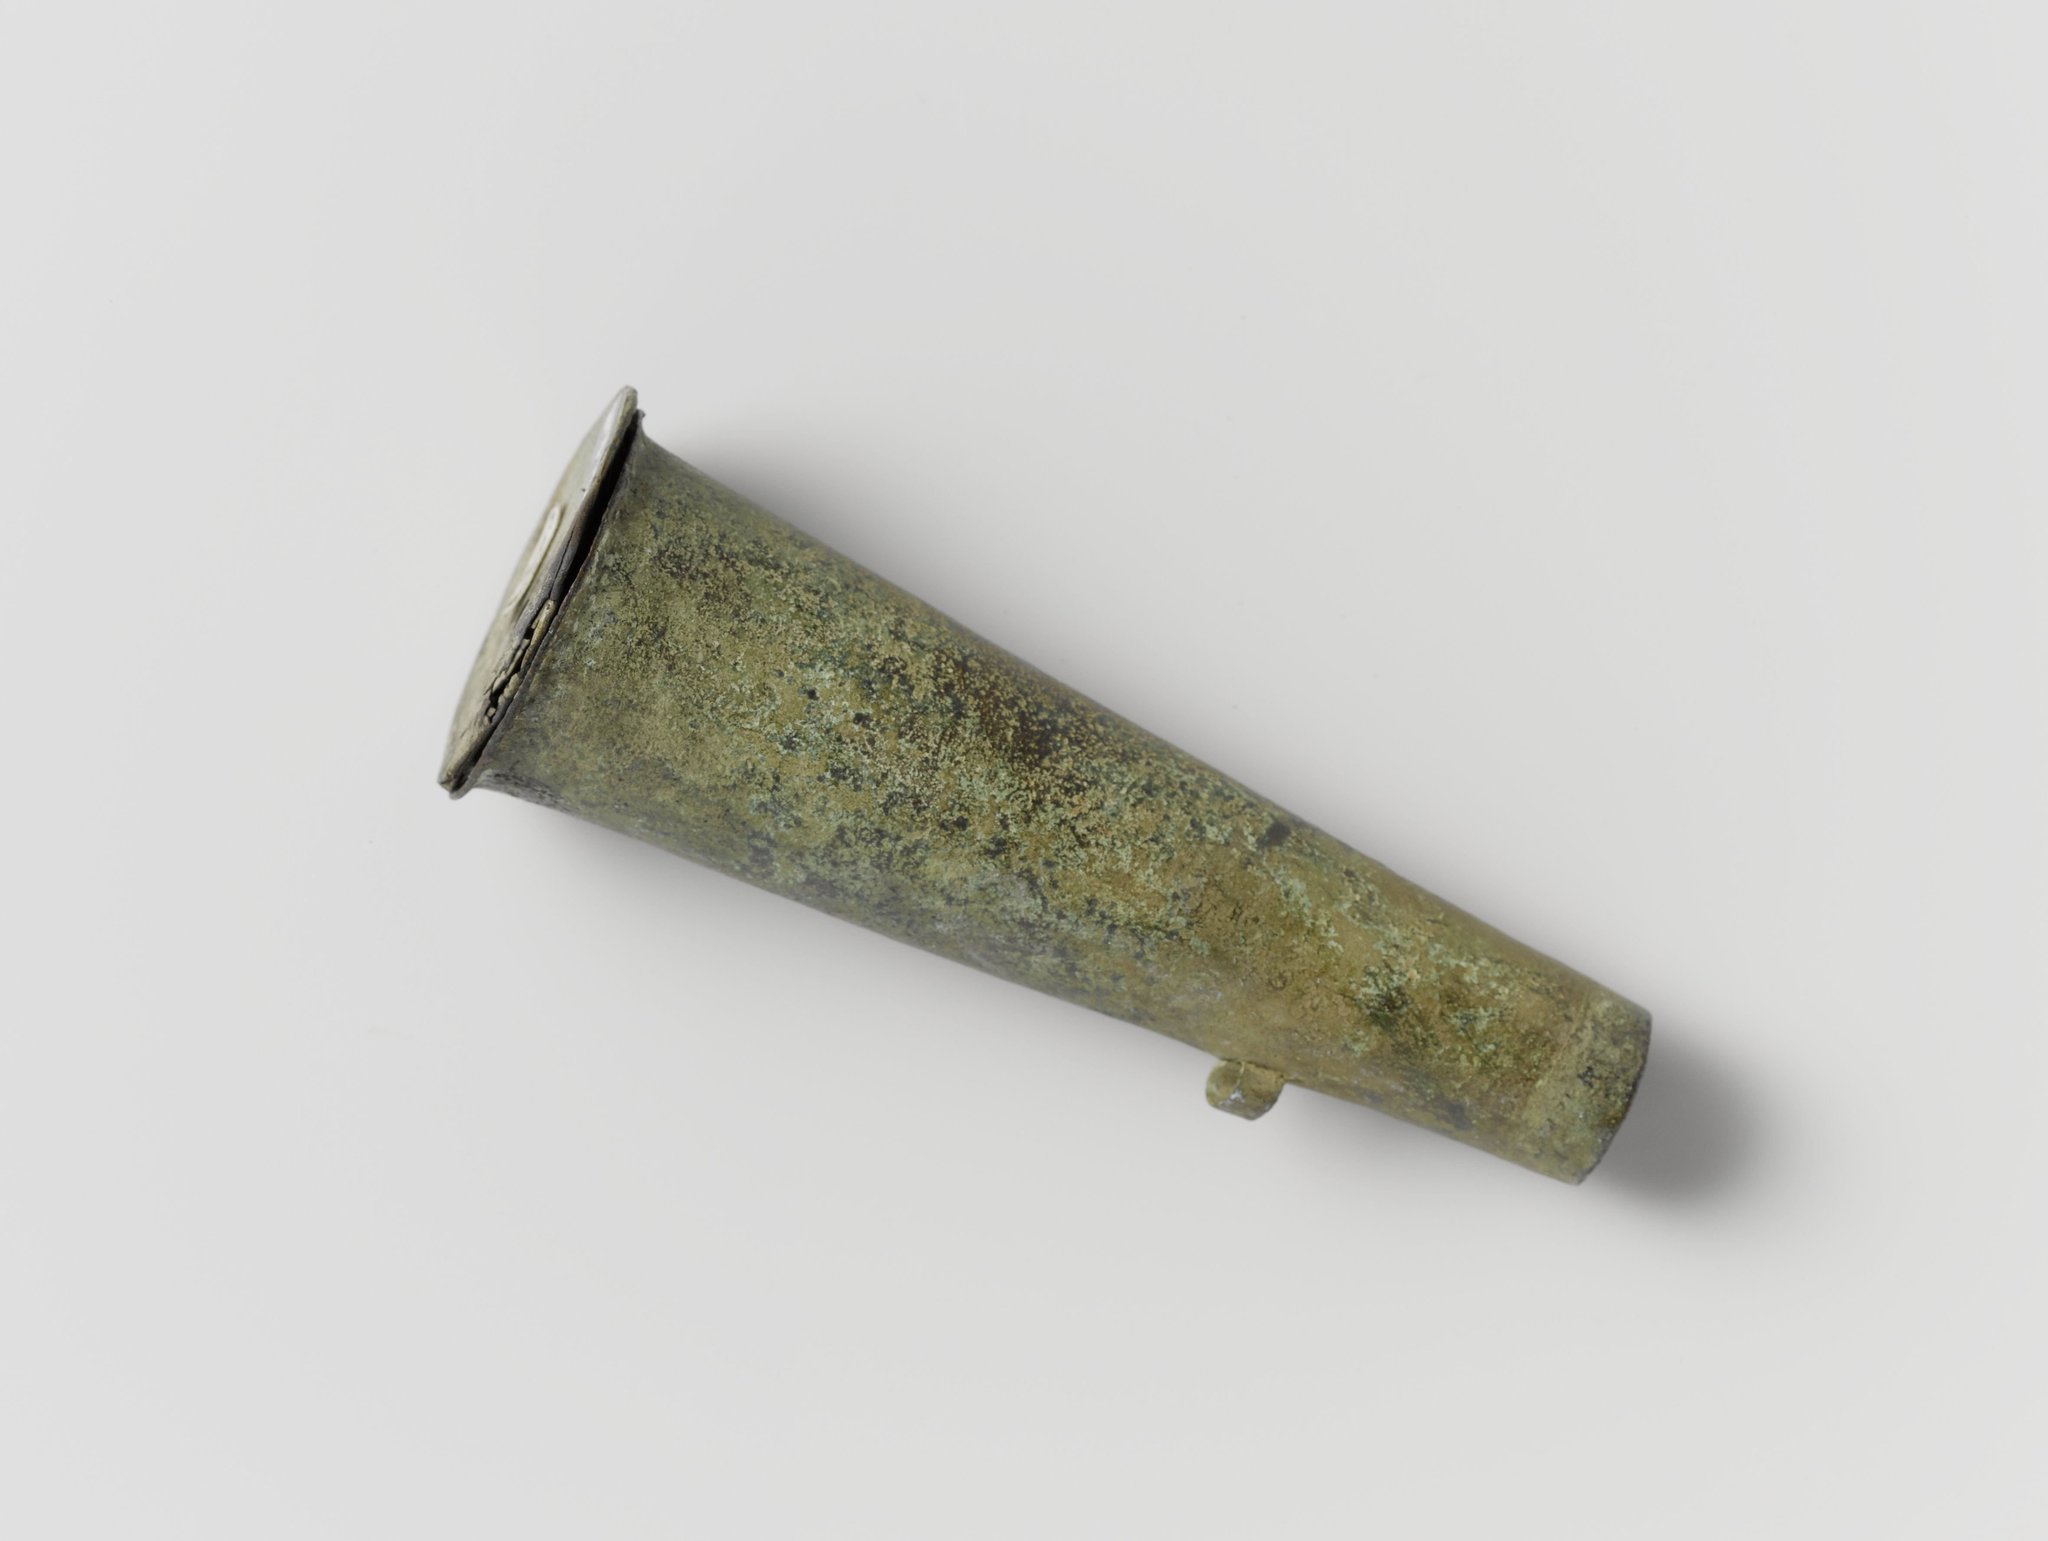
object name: kruitmaat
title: Fragment van musketmaat voor musketbandelier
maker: Anonymous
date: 1590-1596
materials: brass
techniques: striking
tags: willem barendsz., amsterdam, jacob van heemskerck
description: Musketmaat voor musketbandelier, fragment bestaande uit messing huls, losse bodem en één oortje. Lederen bekleding ontbreekt. Standaardbeschrijving musketmaat: messing met leder bekleed. Voorzien van twee oogjes aan de zijkant om een koord door te doen waarmee de deksel werd vastgehouden en het maatje aan de bandelier werd gehangen. Een muskettiersbandelier had twaalf kruitmaatjes en een zakje met kogels. De kruitmaatjes bevatten een zorgvuldig afgepaste hoeveelheid buskruit voor één schot.